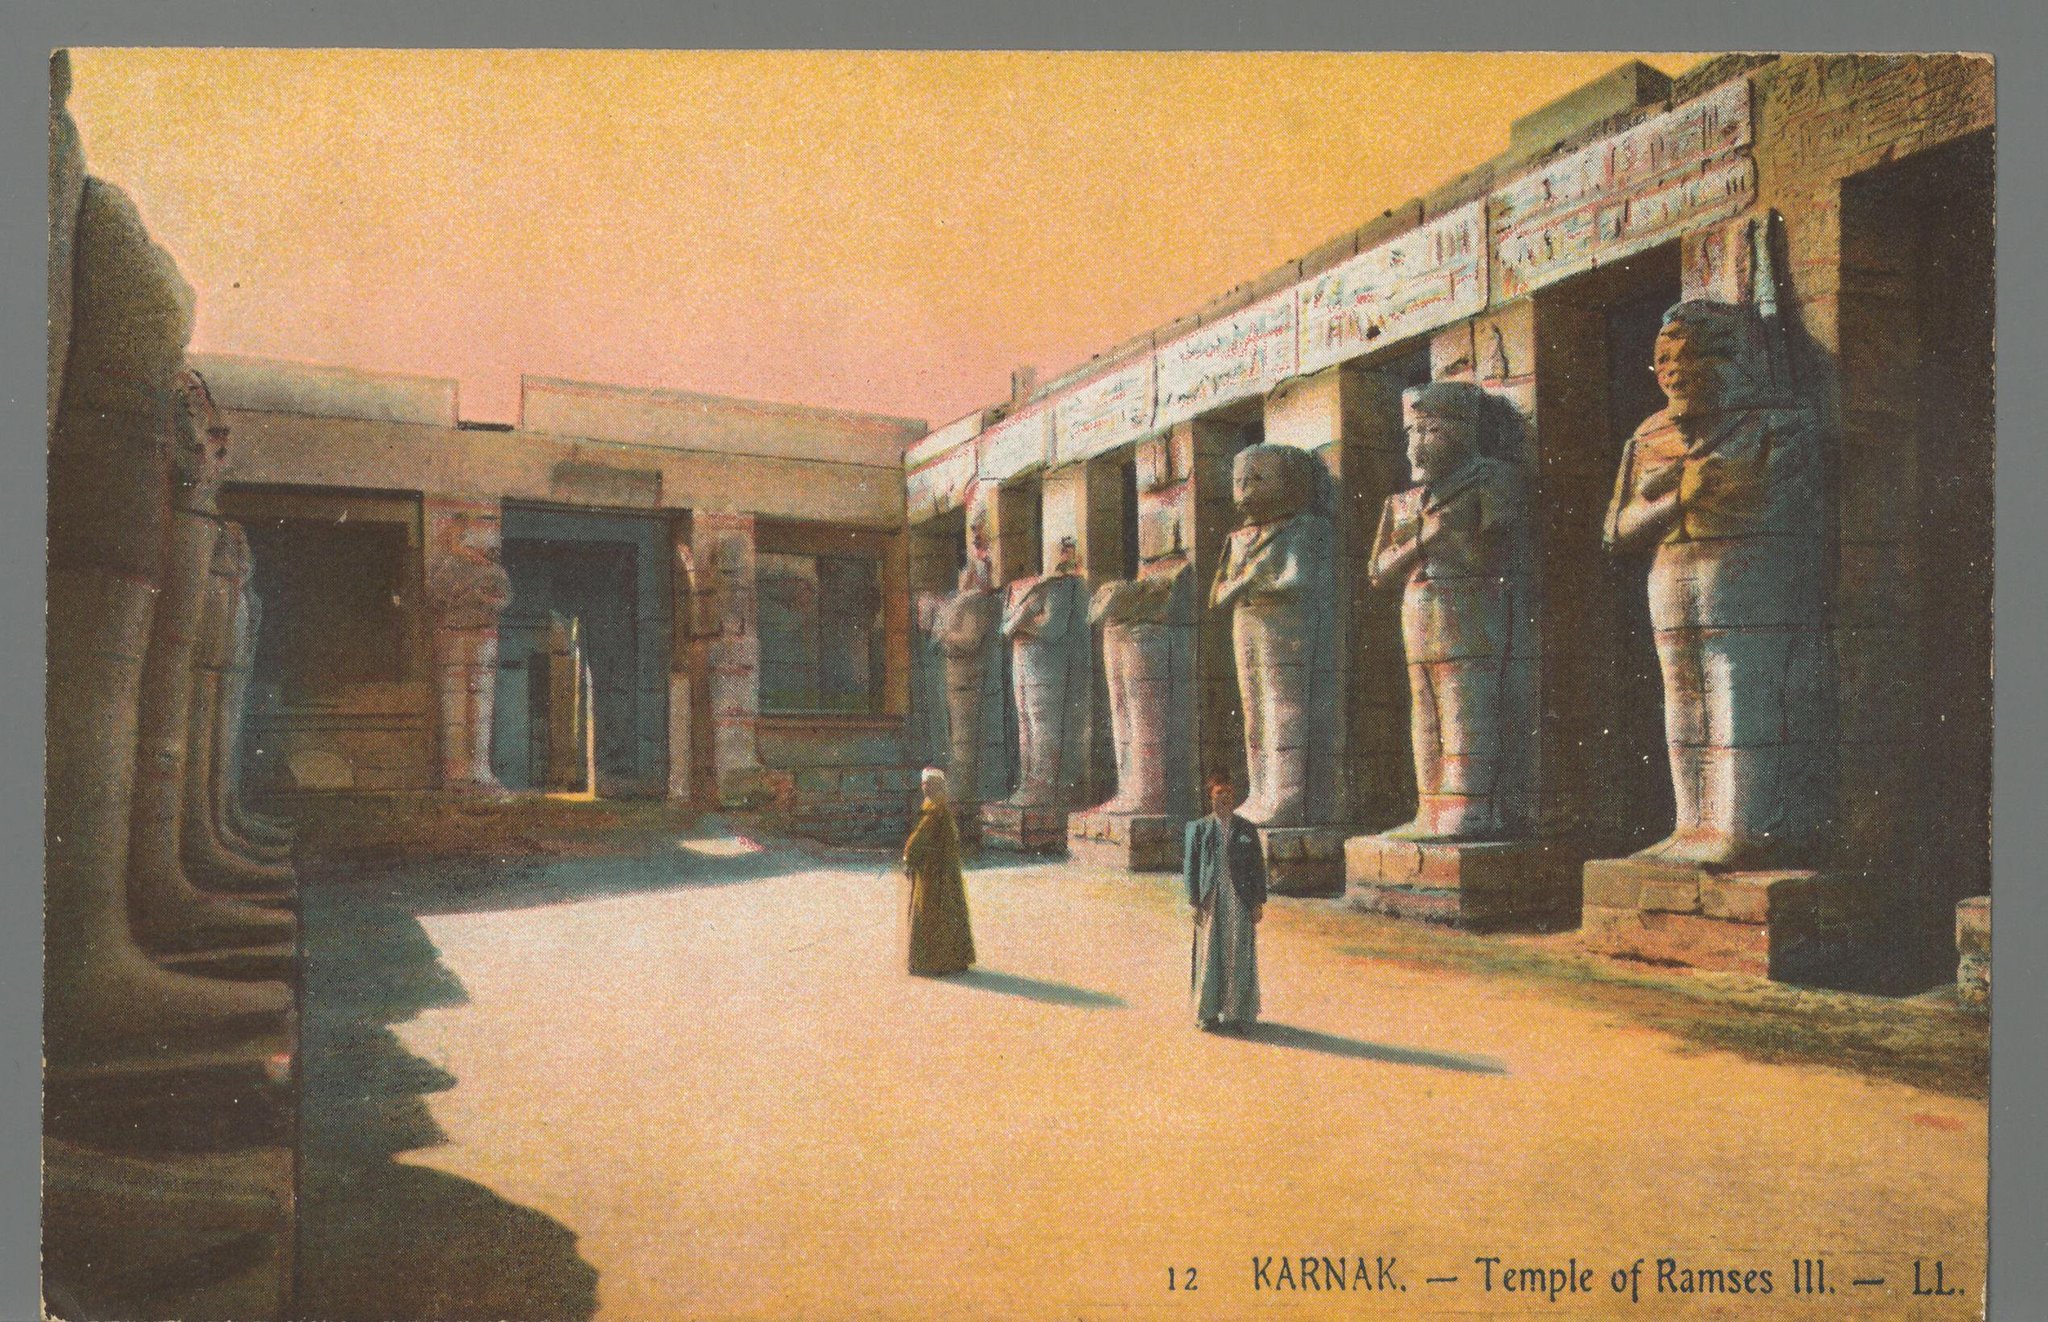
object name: photomechanical print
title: Karnak - Temple of Ramses III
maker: Anonymous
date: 1907-1930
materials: cardboard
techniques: lithograph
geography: paris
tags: temple, shrine ~ egyptian religion, statues, paintings, etc. ~ objects of worship (egyptian religion)